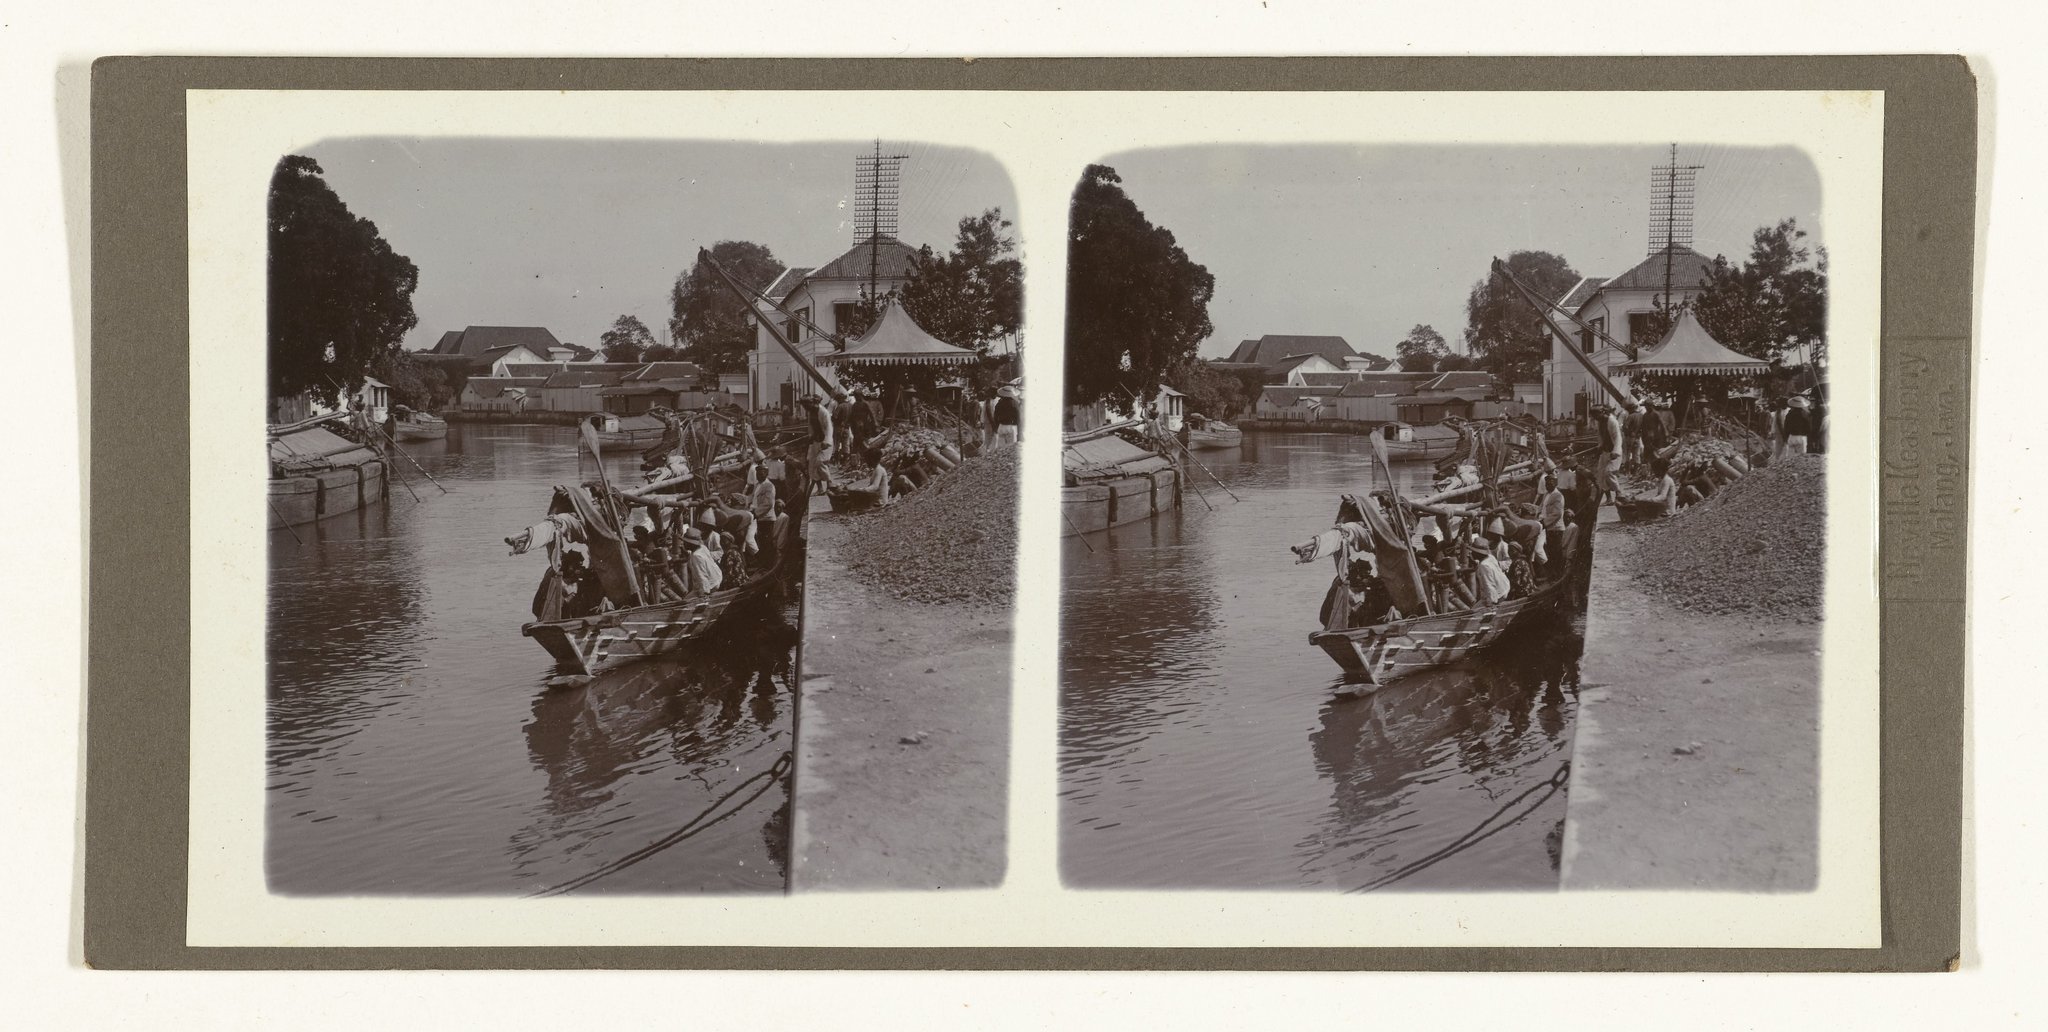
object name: stereograph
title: Overvolle aanmerende boot bij de Willemskade in Surabaya.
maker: neville keasberry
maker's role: fotograaf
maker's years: 1866-1944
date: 1900-1935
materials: cardboard, paper, photographic support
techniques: albumen print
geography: malang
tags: surabaya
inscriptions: signature: ‘Neville Keasberry, Malang (Java)’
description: Een boot meert aan bij de Willemskade in Surabaya. Op de kade is het druk met mensen.